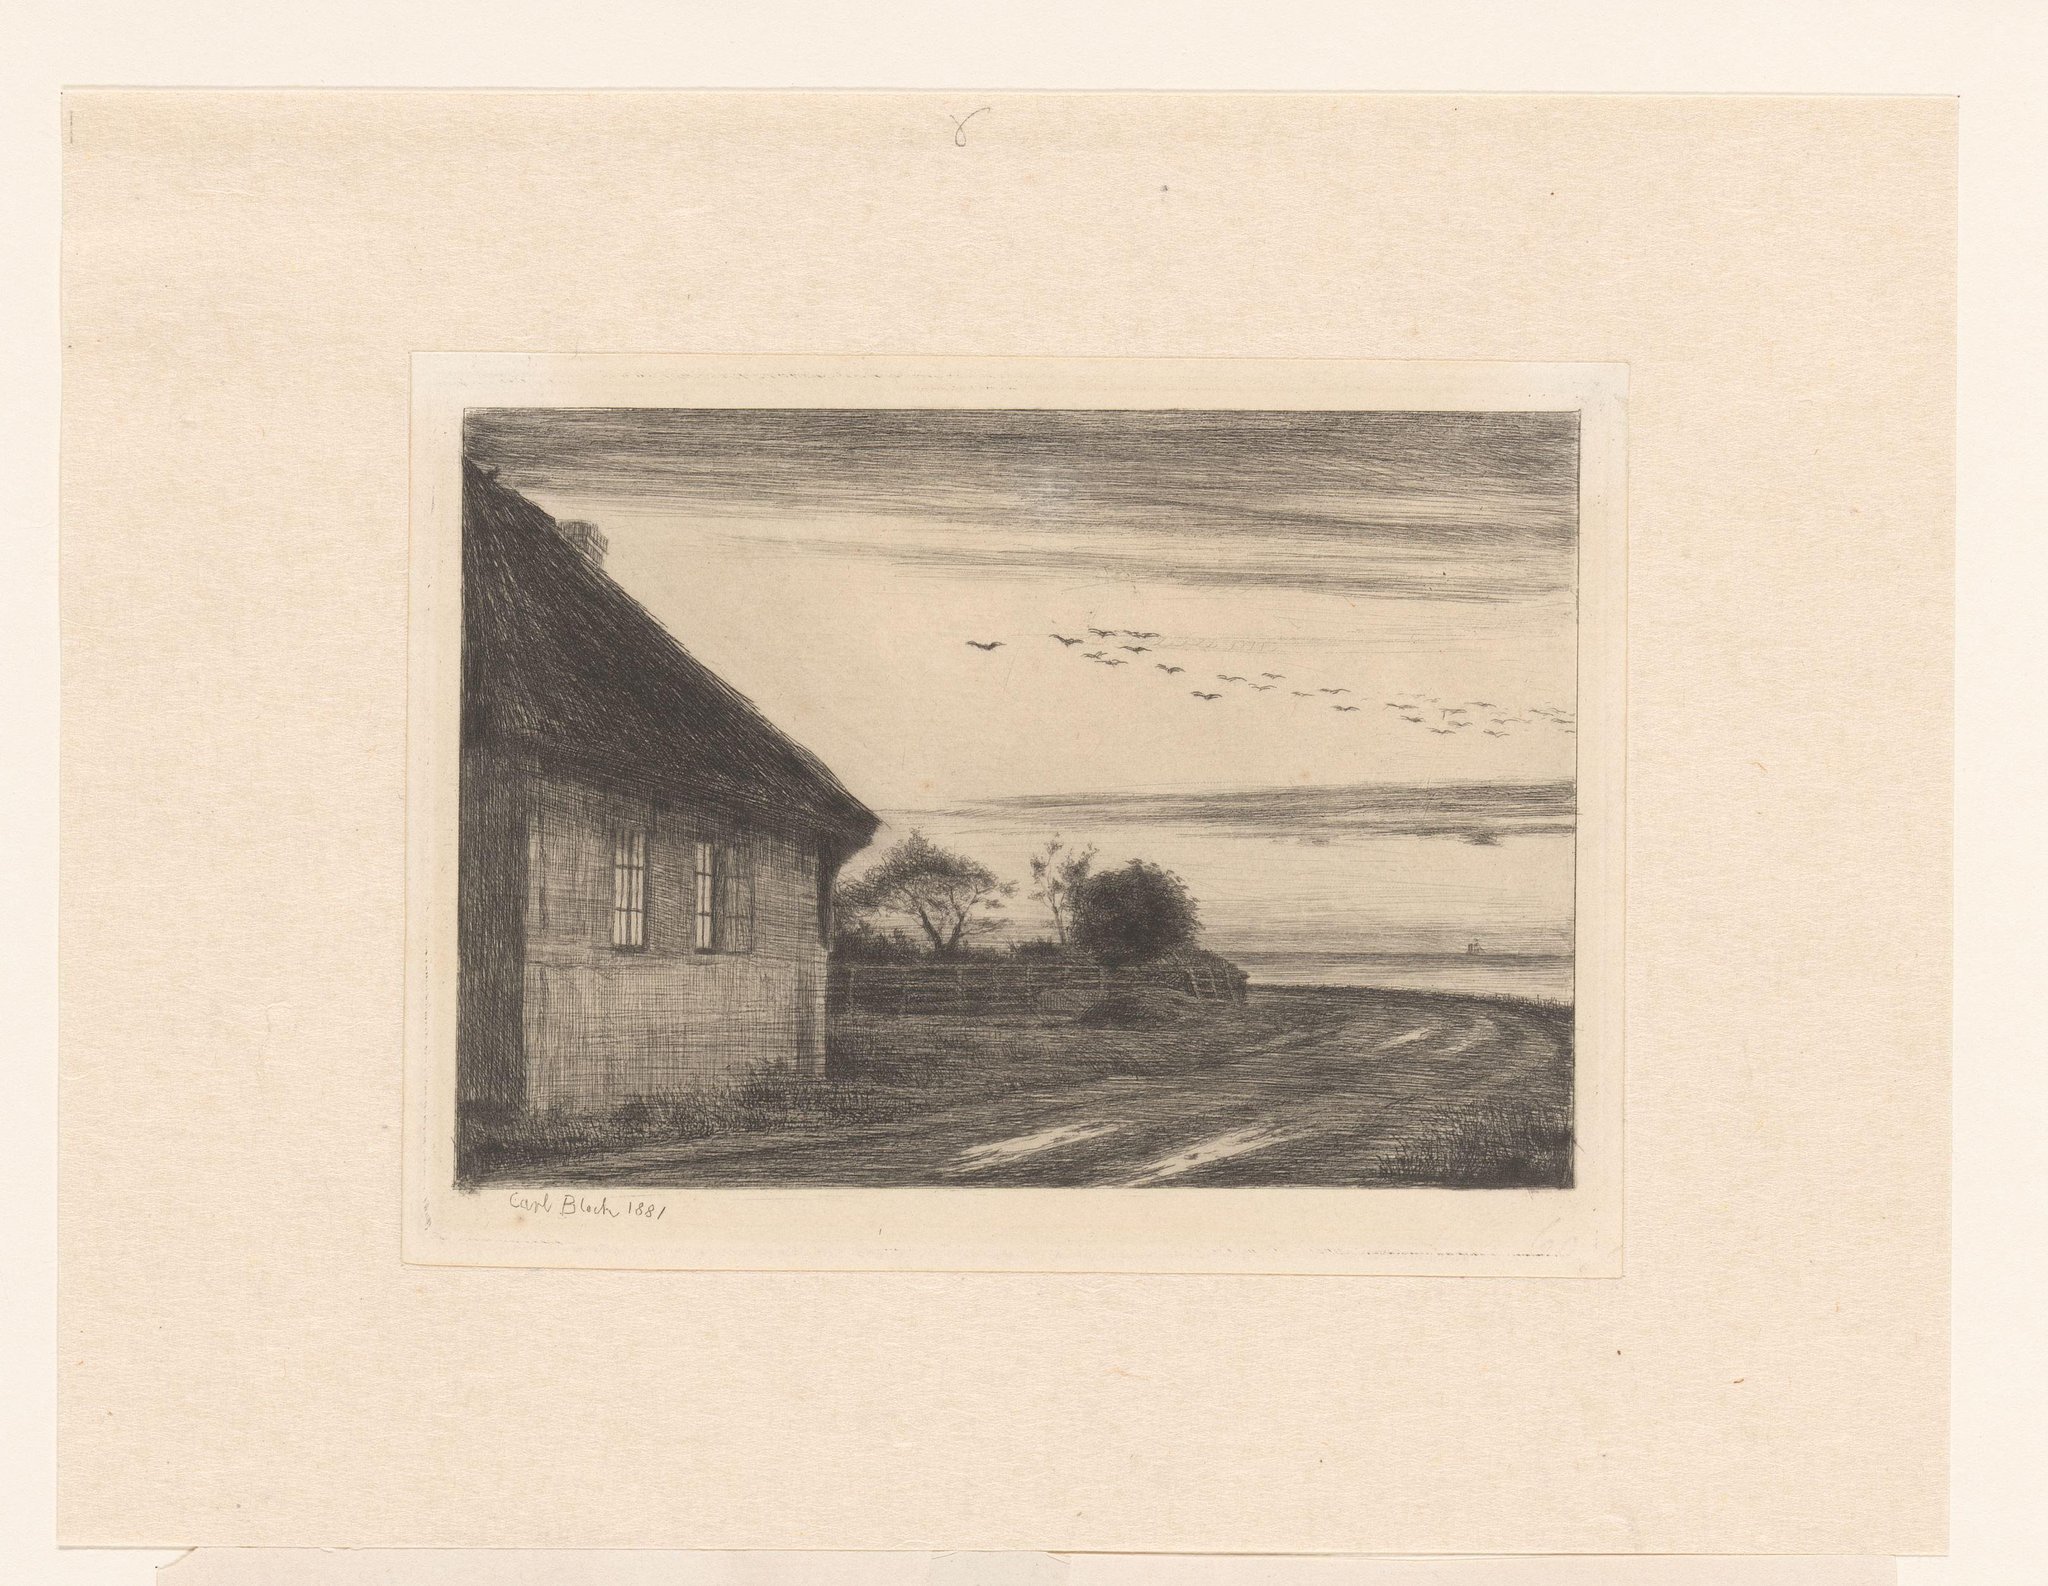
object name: print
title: Huis aan landweg aan water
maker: carl bloch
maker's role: print maker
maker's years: 1834-1890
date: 1881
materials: paper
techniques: drypoint, etching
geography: scandinavia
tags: road, path, farm or solitary house in landscape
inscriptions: collector's mark: Lugt 2228, signature and date: ‘l.o. in de marge gesigneerd en gedateerd Carl Bloch, 1881’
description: Links gedeelte van een huis te zien, liggend aan een landweg die langs het water loopt. In de lucht een zwerm vogels.